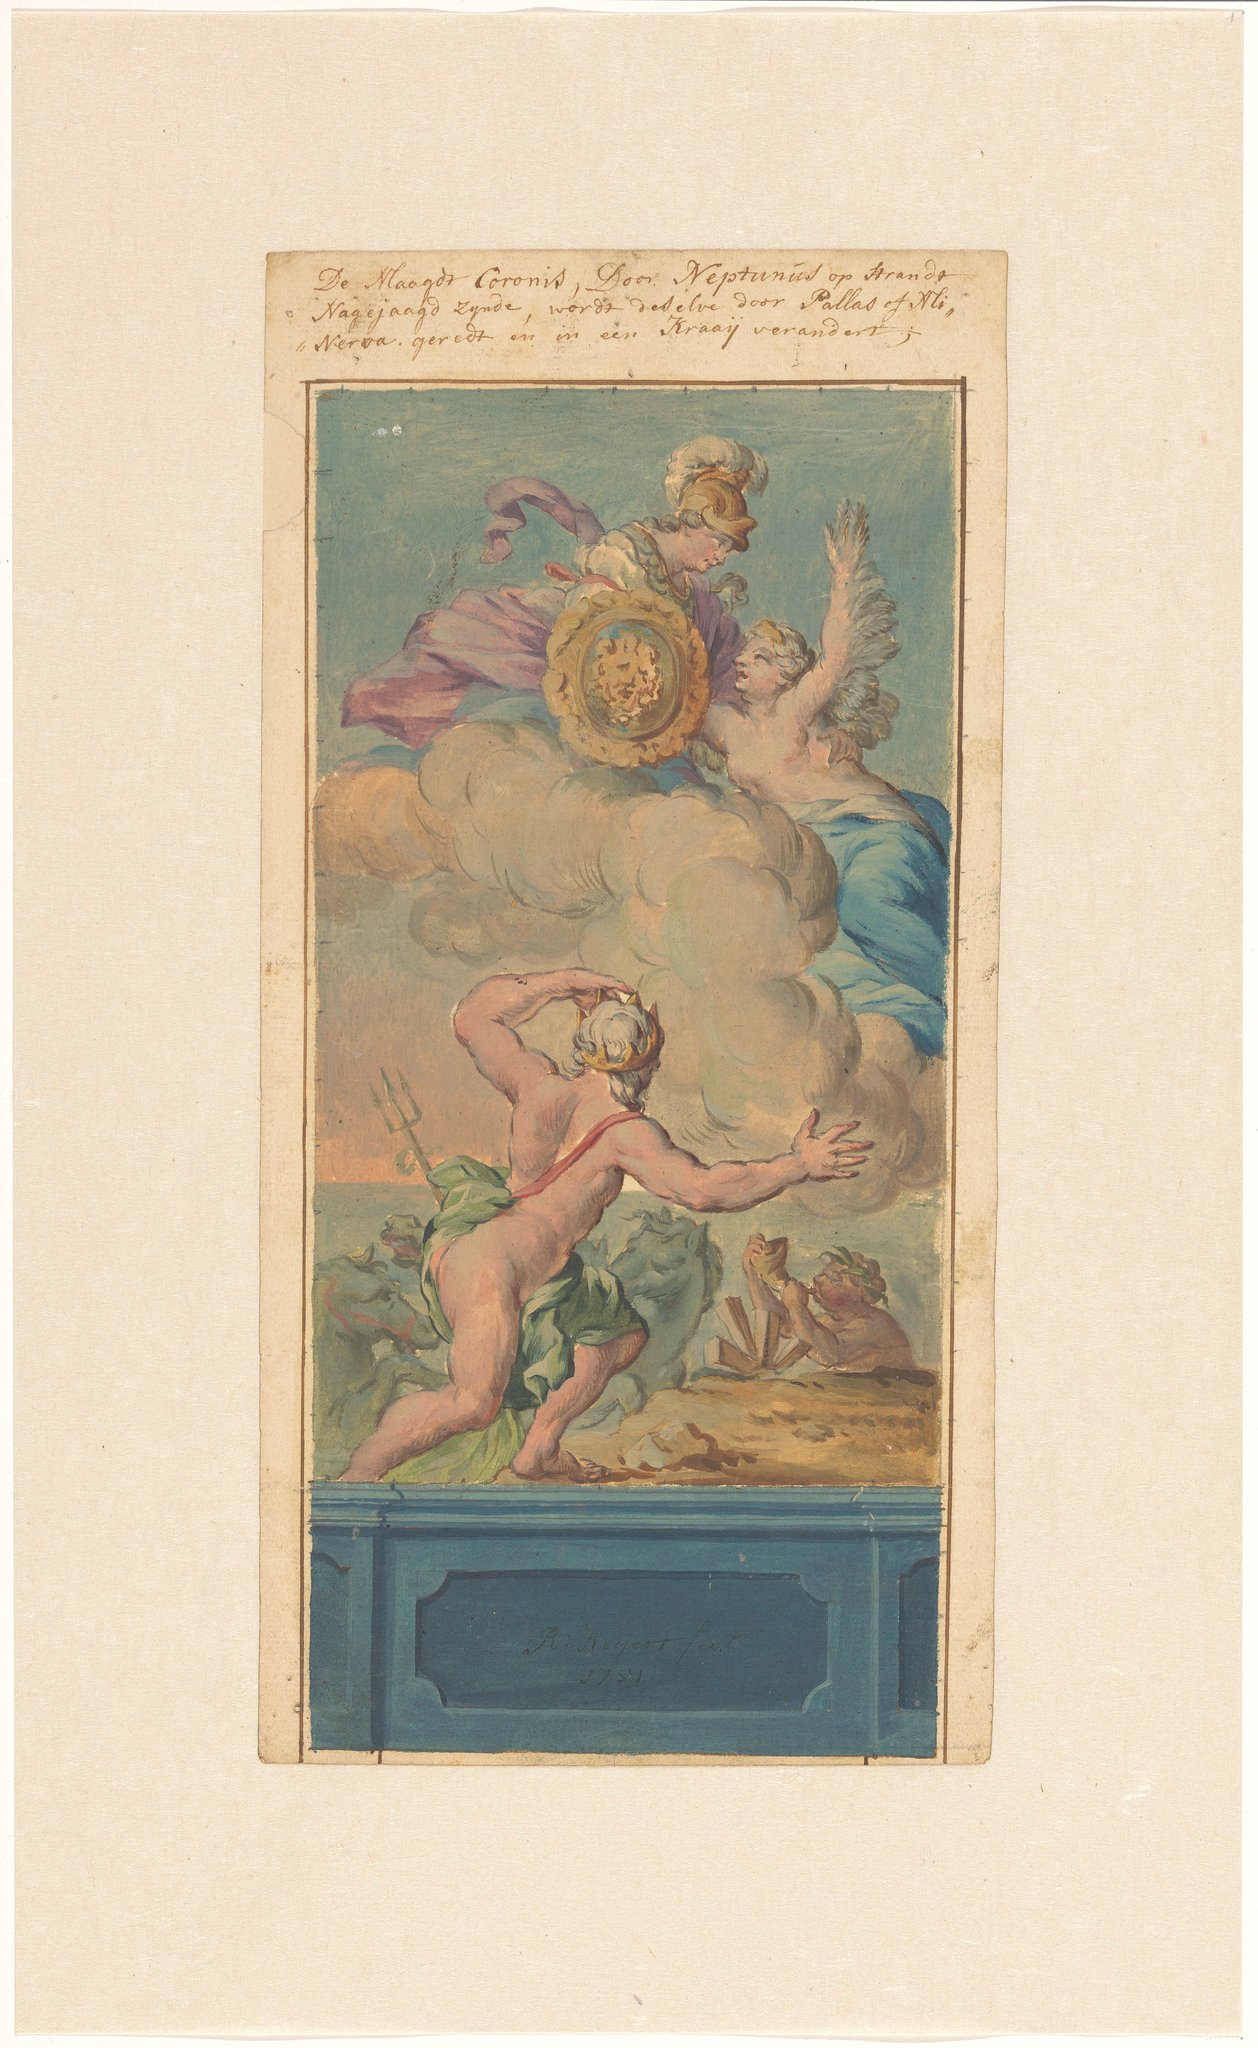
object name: drawing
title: Ontwerp voor een behangselschildering met Coronis en Minerva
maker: rienk keyert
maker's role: draughtsman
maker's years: 1709-1775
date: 1751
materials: paper, watercolor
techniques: brush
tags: (story of) minerva (pallas, athena), coronis changed into a crow: to escape the love of neptune, coronis, daughter of coroneus, is changed into a crow by minerva (ovid, metamorphoses ii 569)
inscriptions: date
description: Behoort tot hetzelfde decoratieproject als inv. RP-T-1906-10.